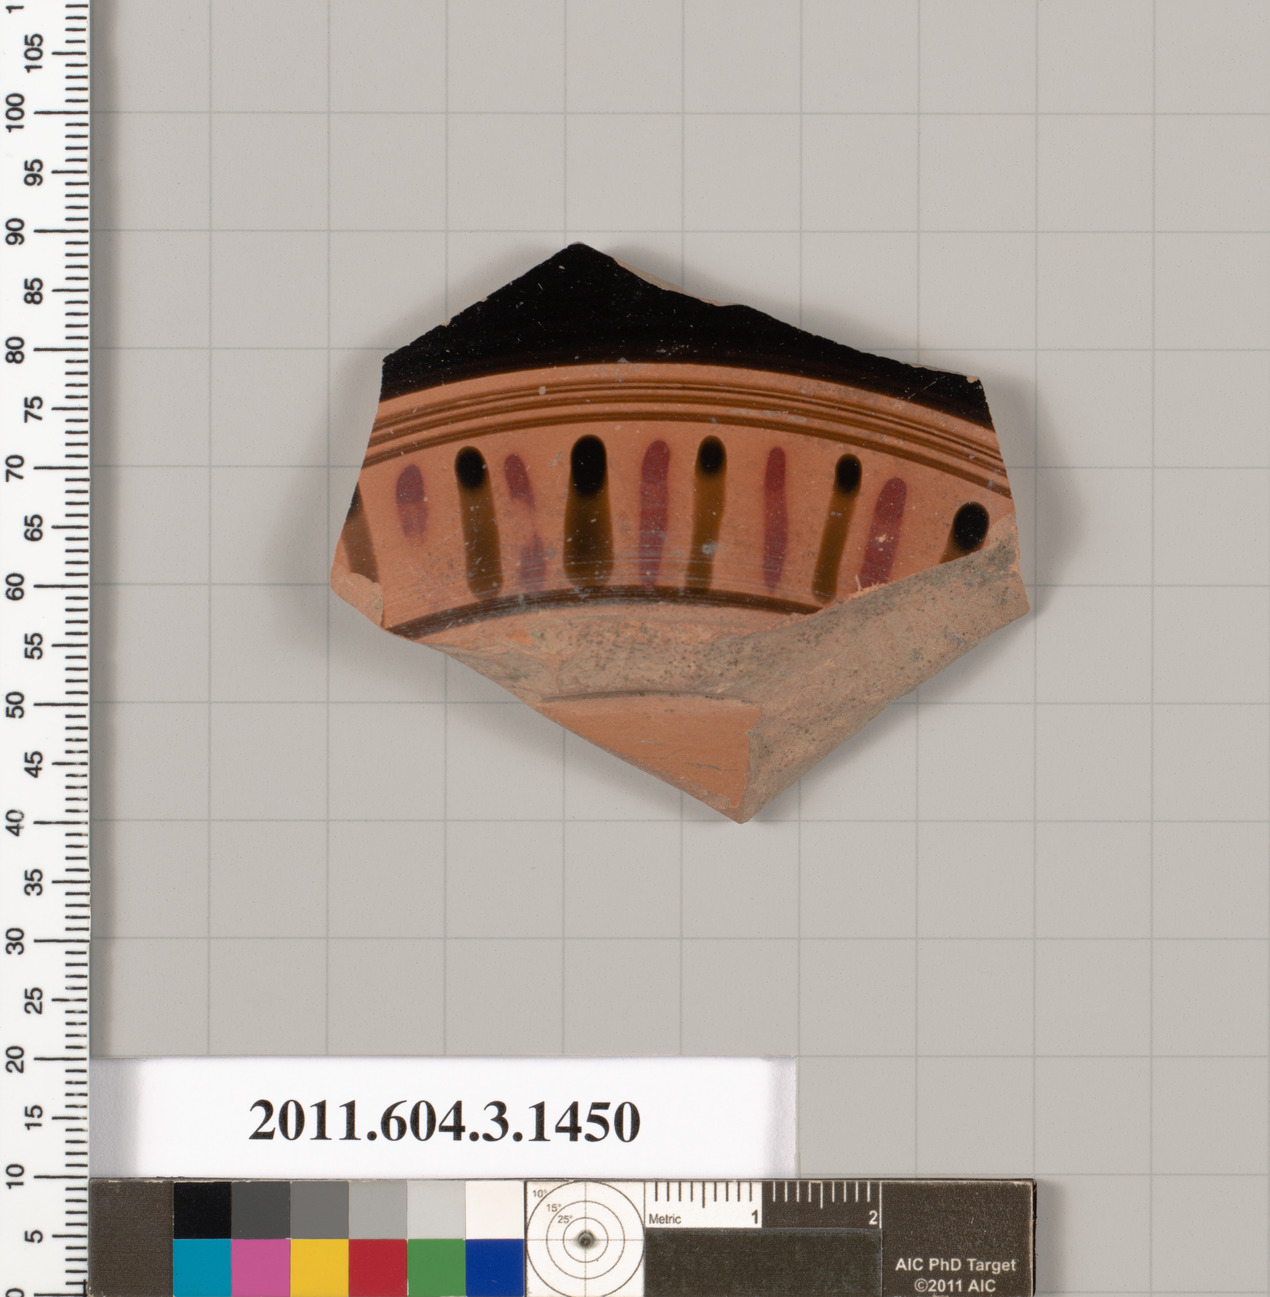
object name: skyphos fragment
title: Terracotta fragment of a skyphos (deep drinking cup)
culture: greek, attic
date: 534-468 BCE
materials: terracotta